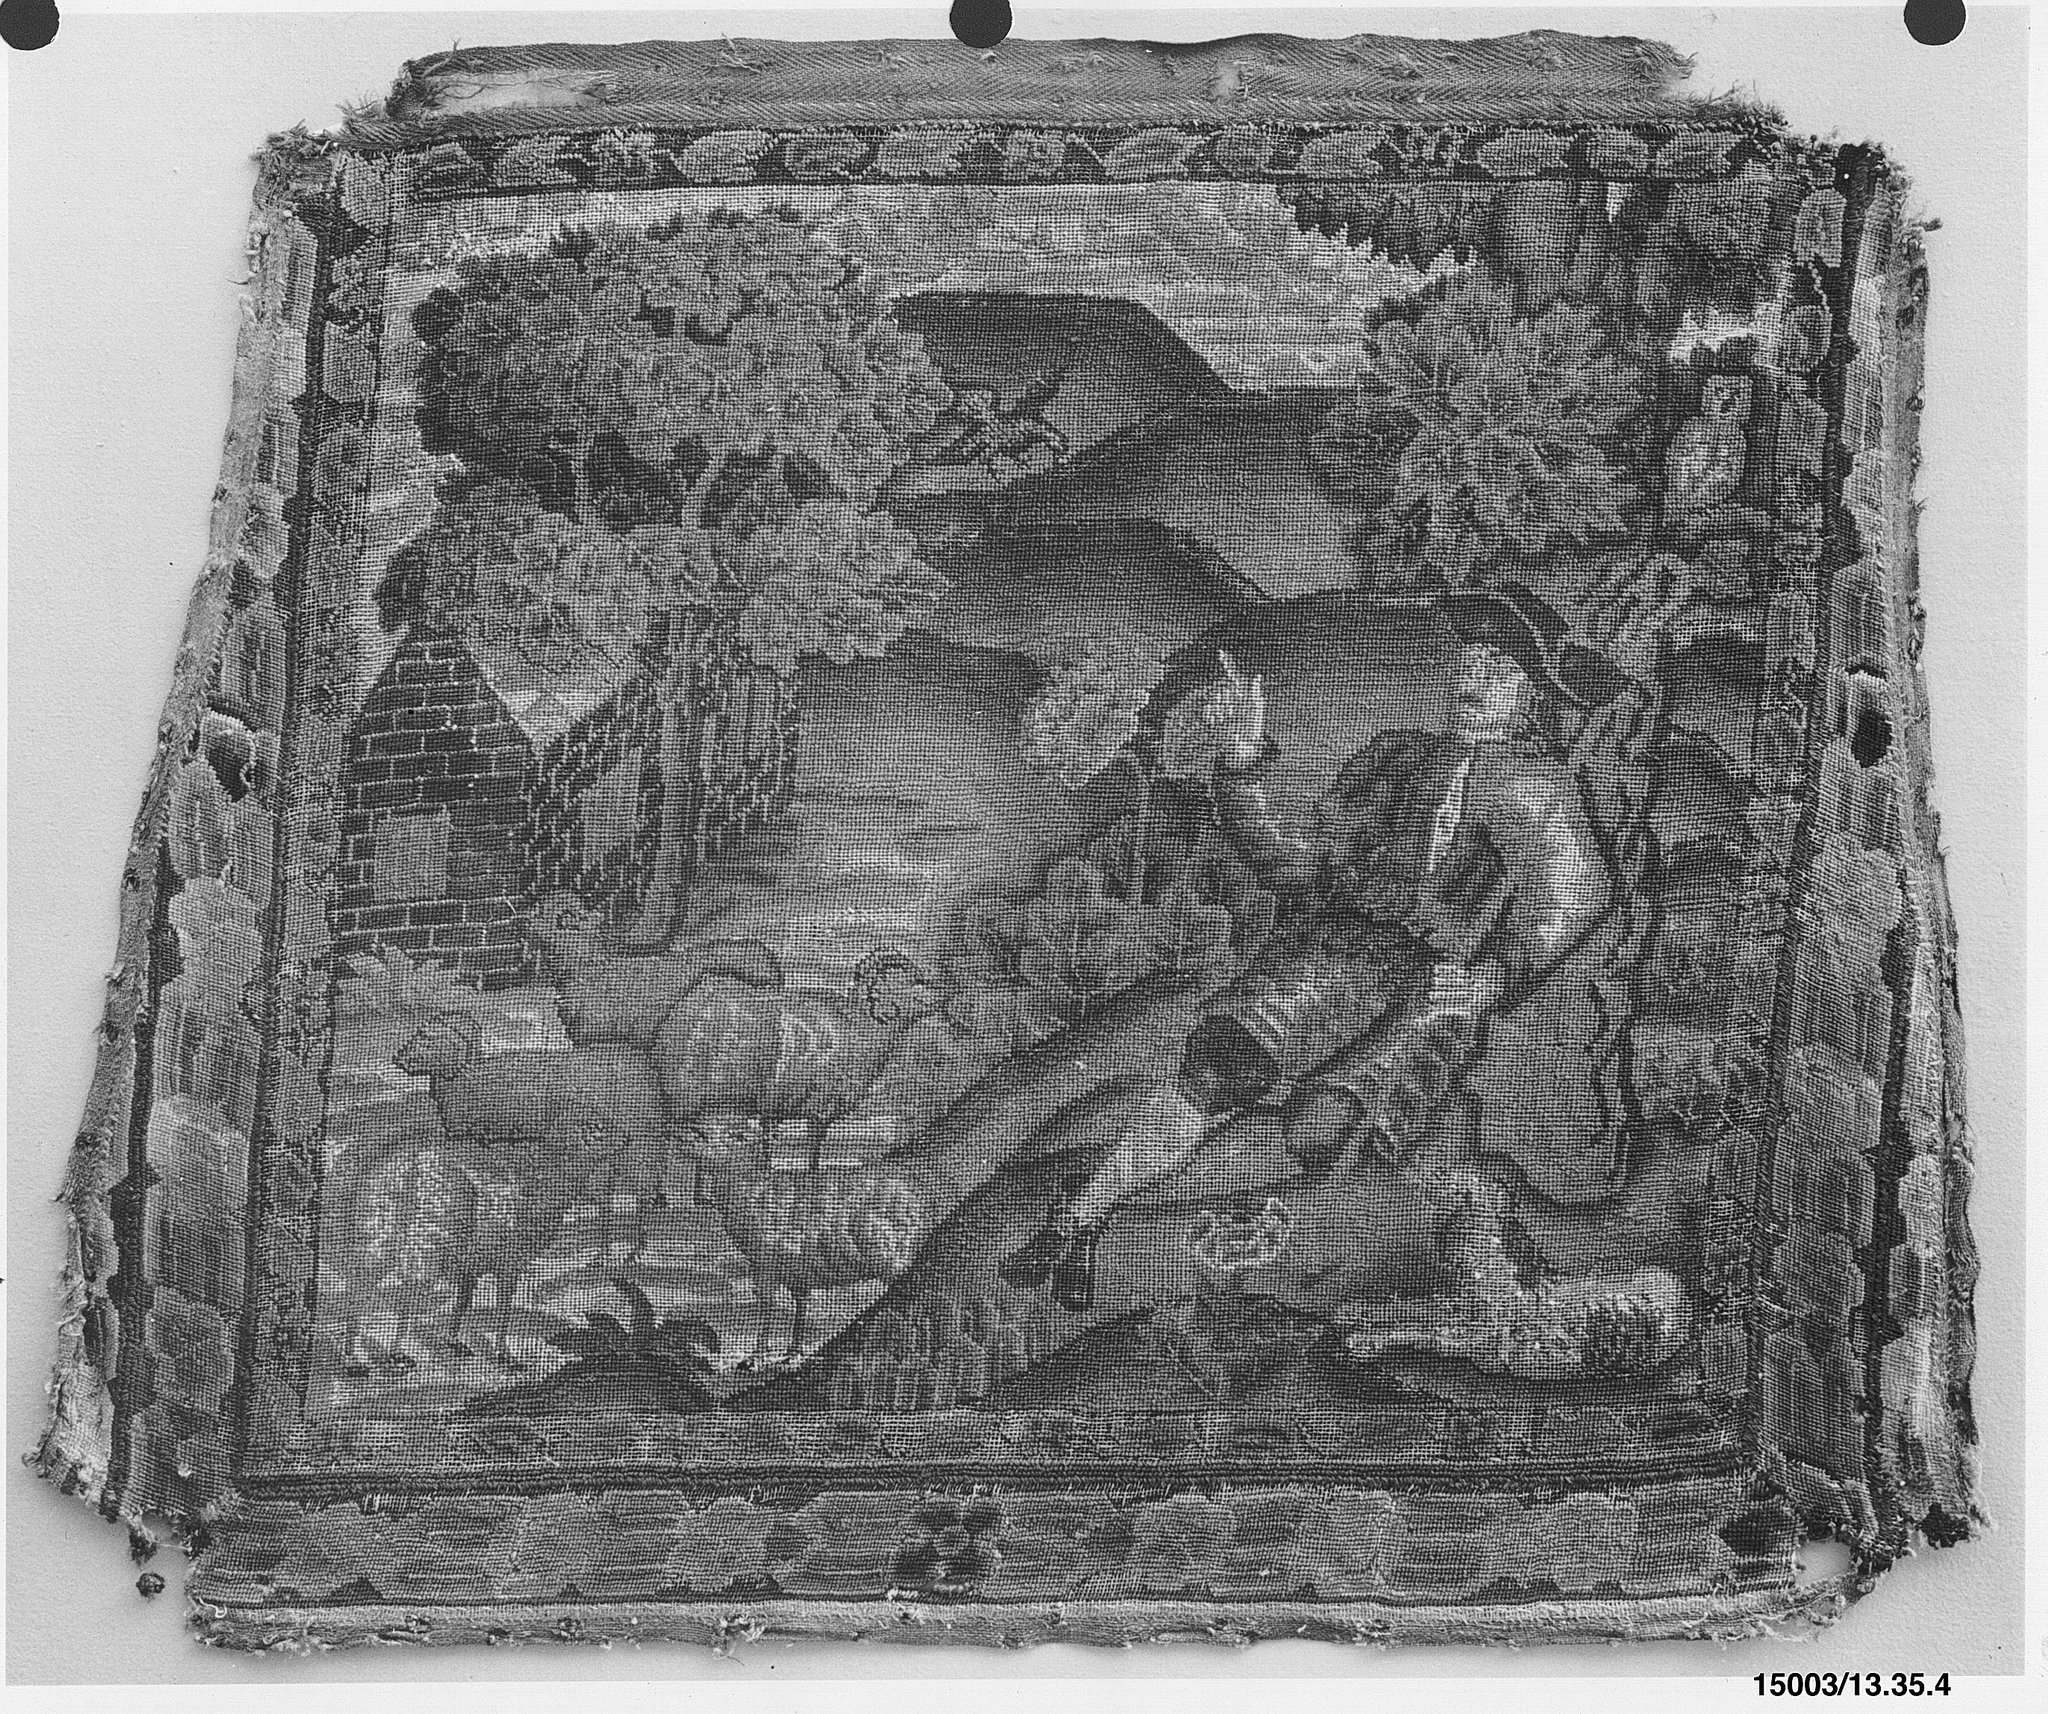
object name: cover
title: Chair seat cover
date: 1701-1800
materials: silk, wool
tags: houses,men,sheep,trees